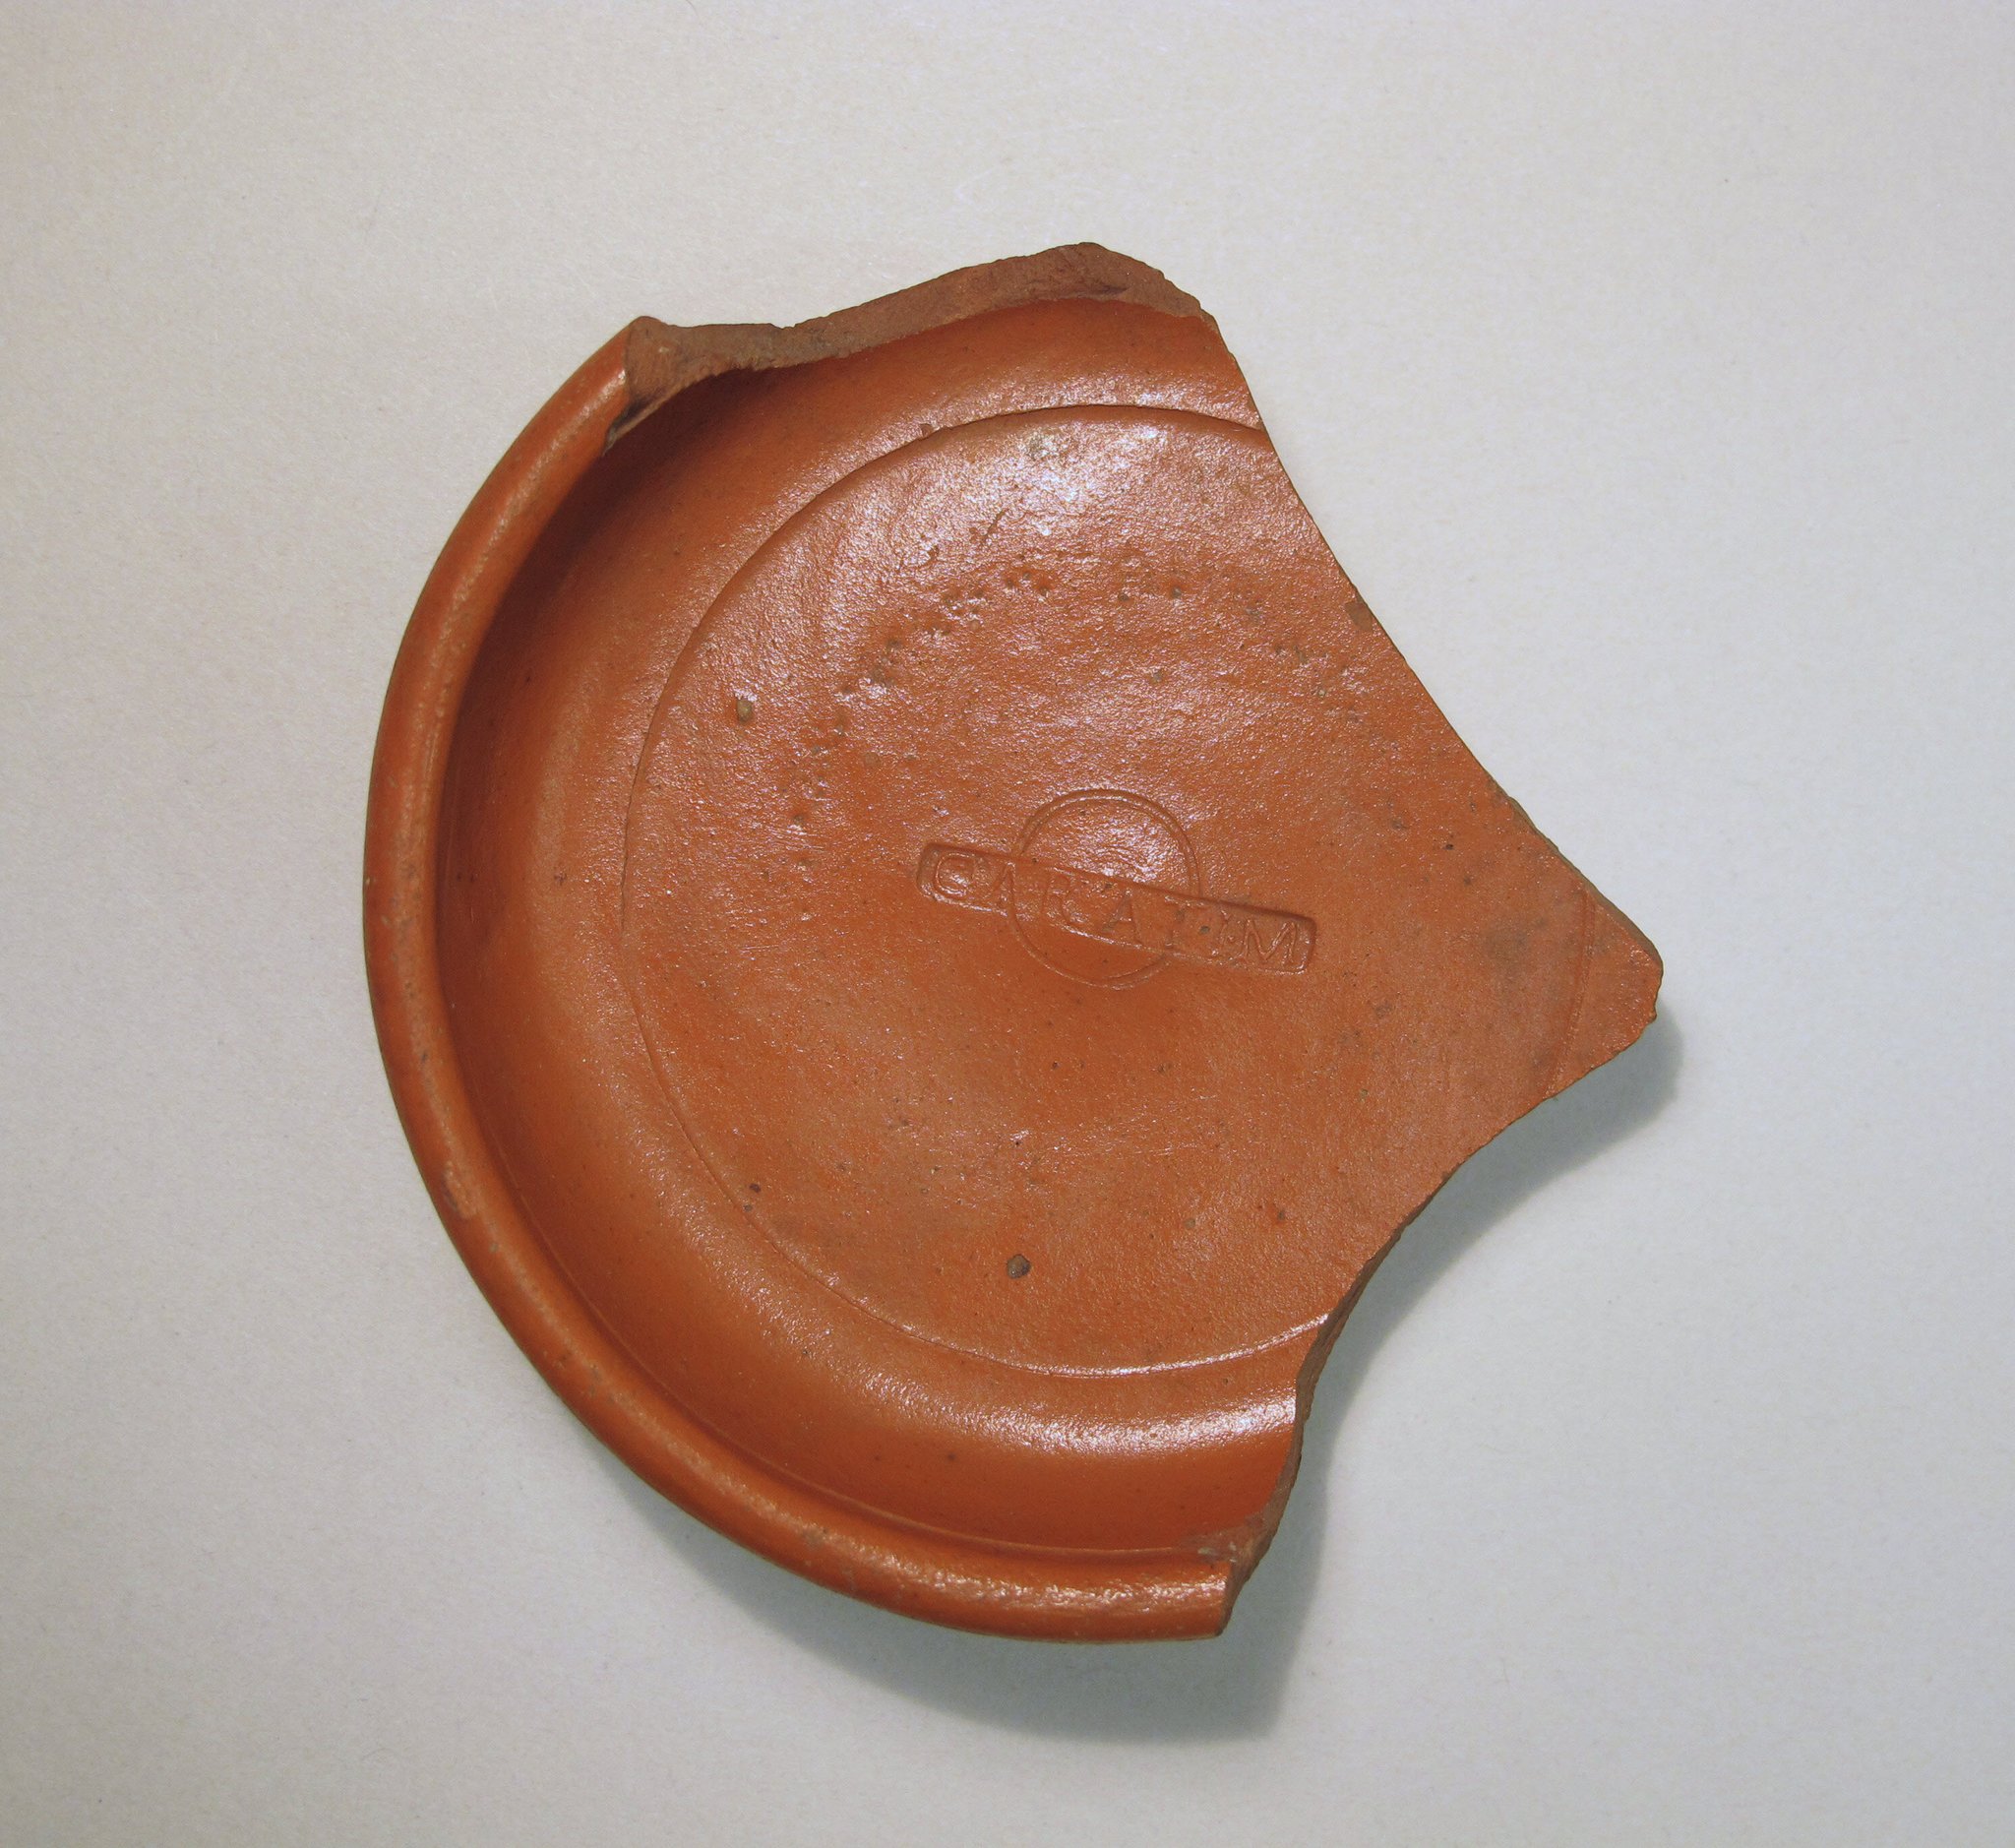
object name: vase fragment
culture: roman, gaul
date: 120 BCE-300 CE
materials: terracotta